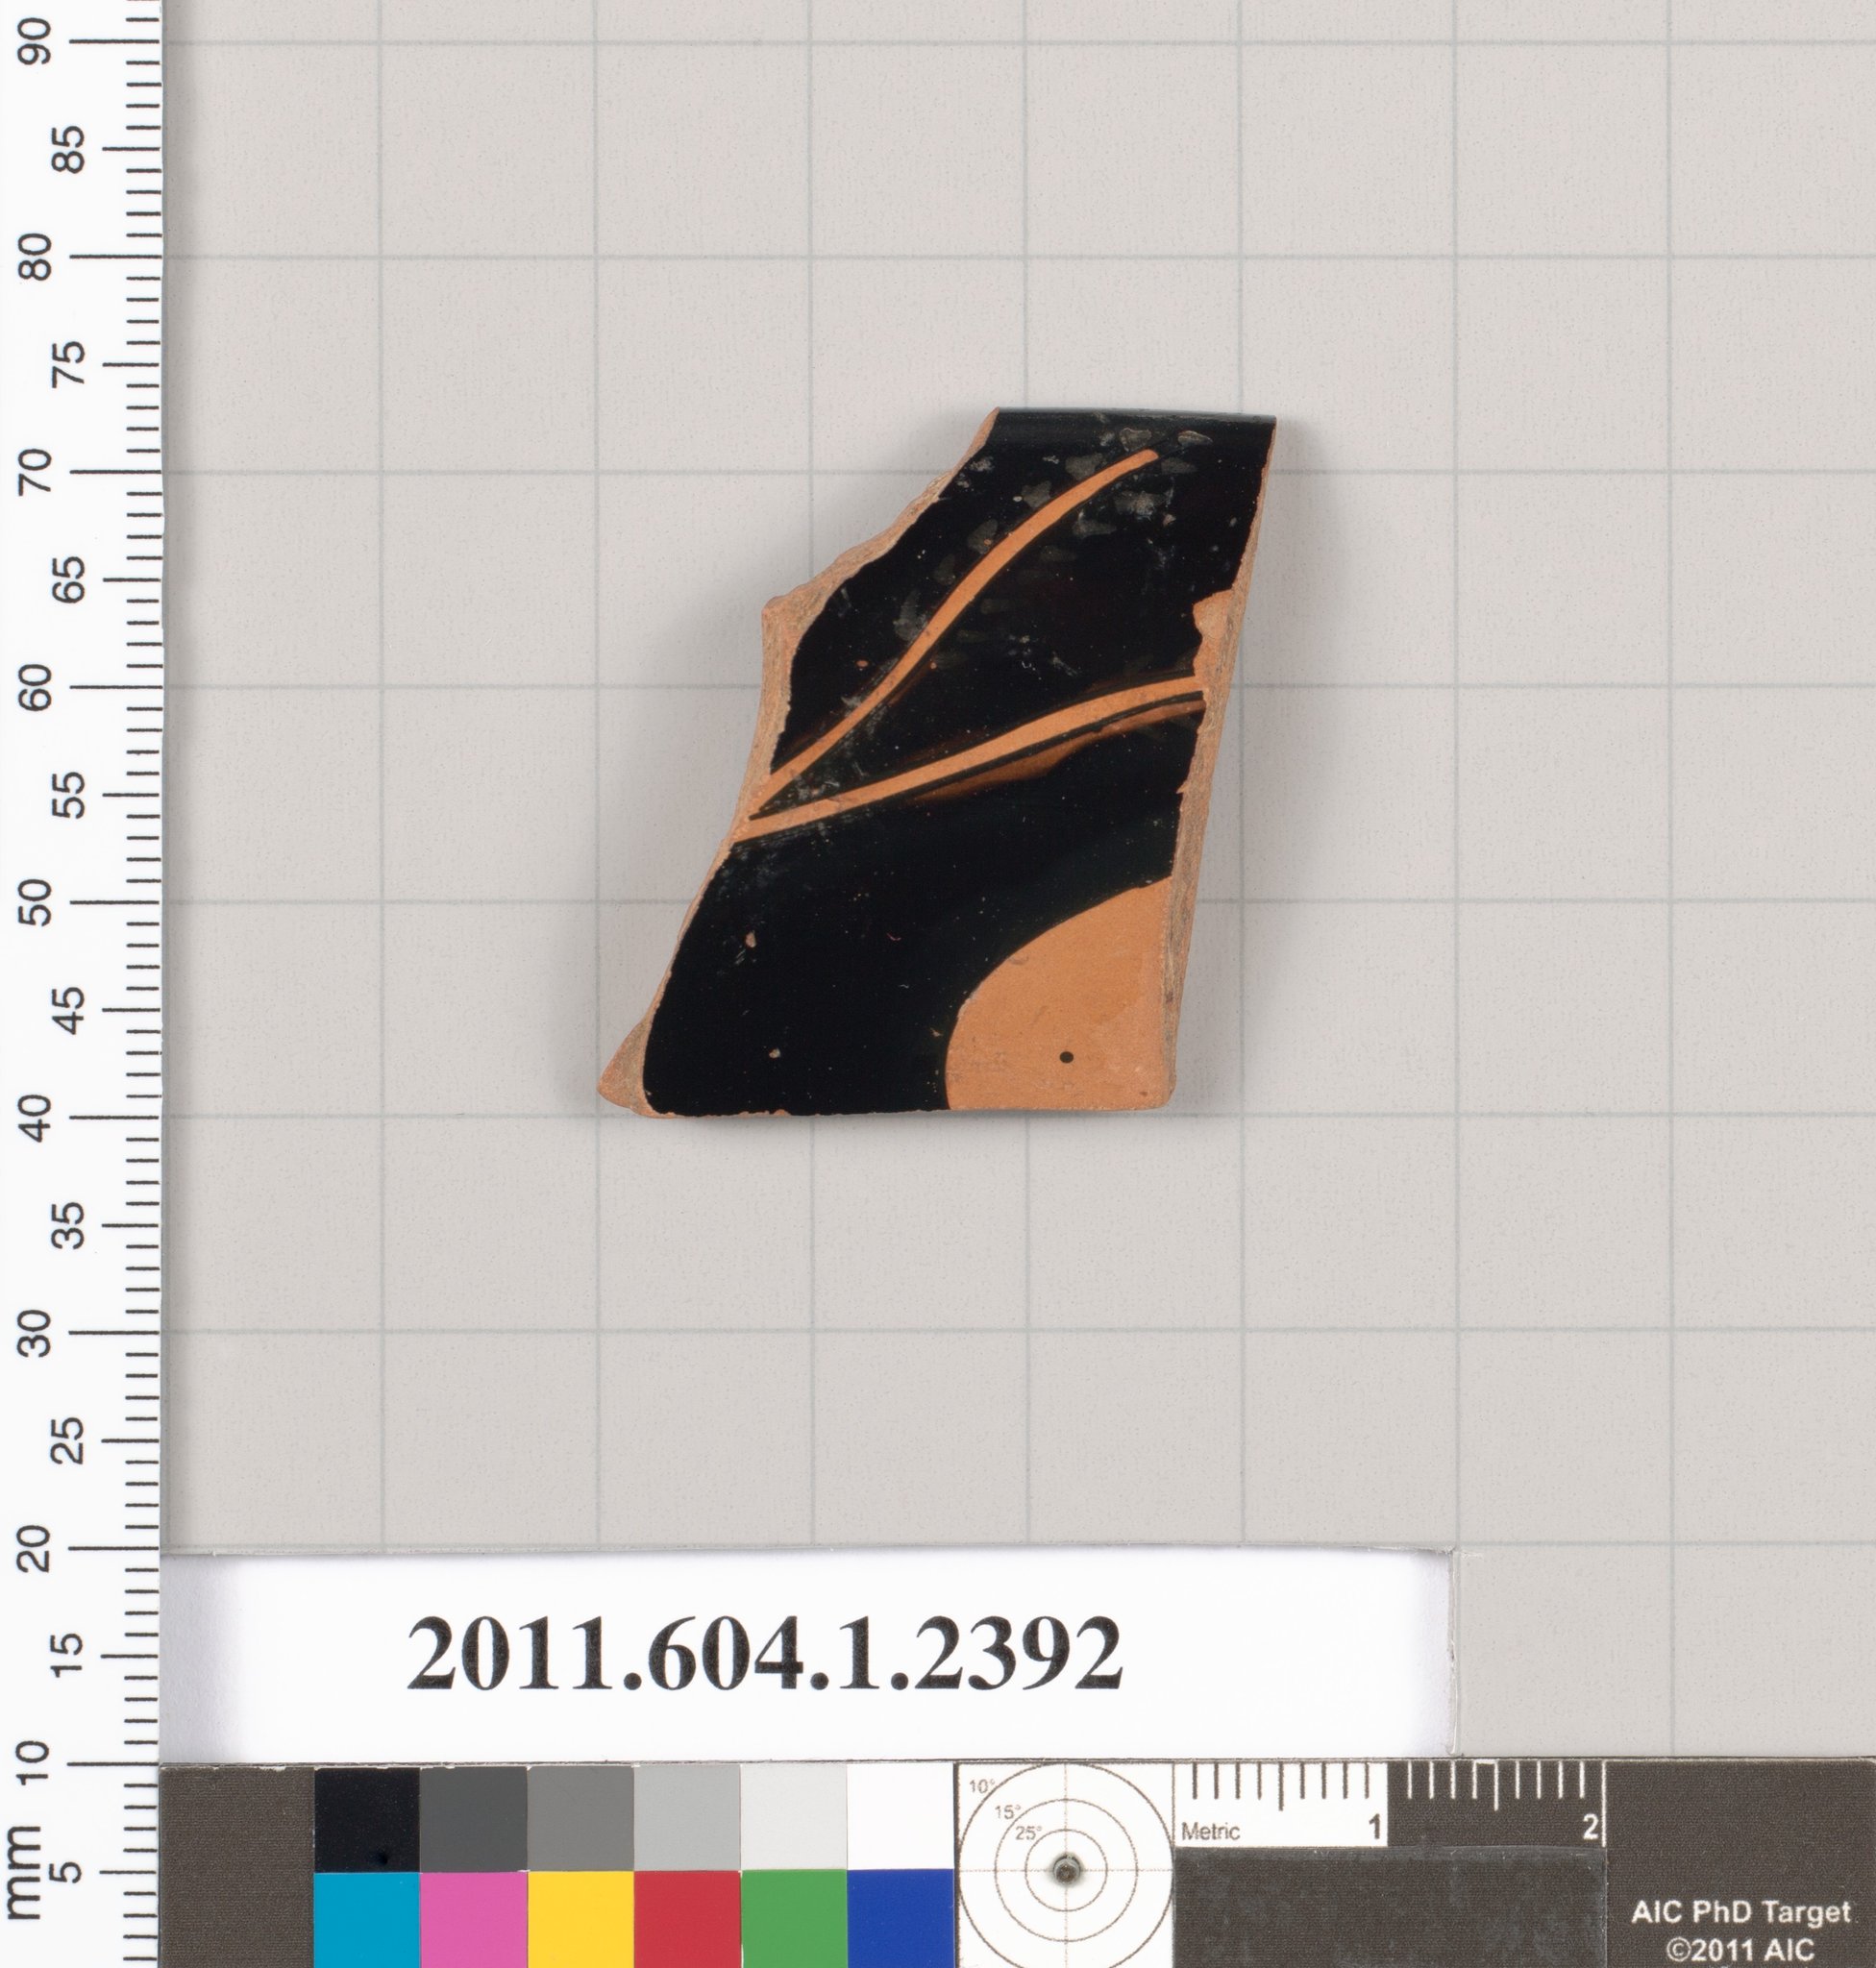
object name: kylix fragment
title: Terracotta rim fragment of a kylix (drinking cup)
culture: greek, attic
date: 500-490 BCE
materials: terracotta